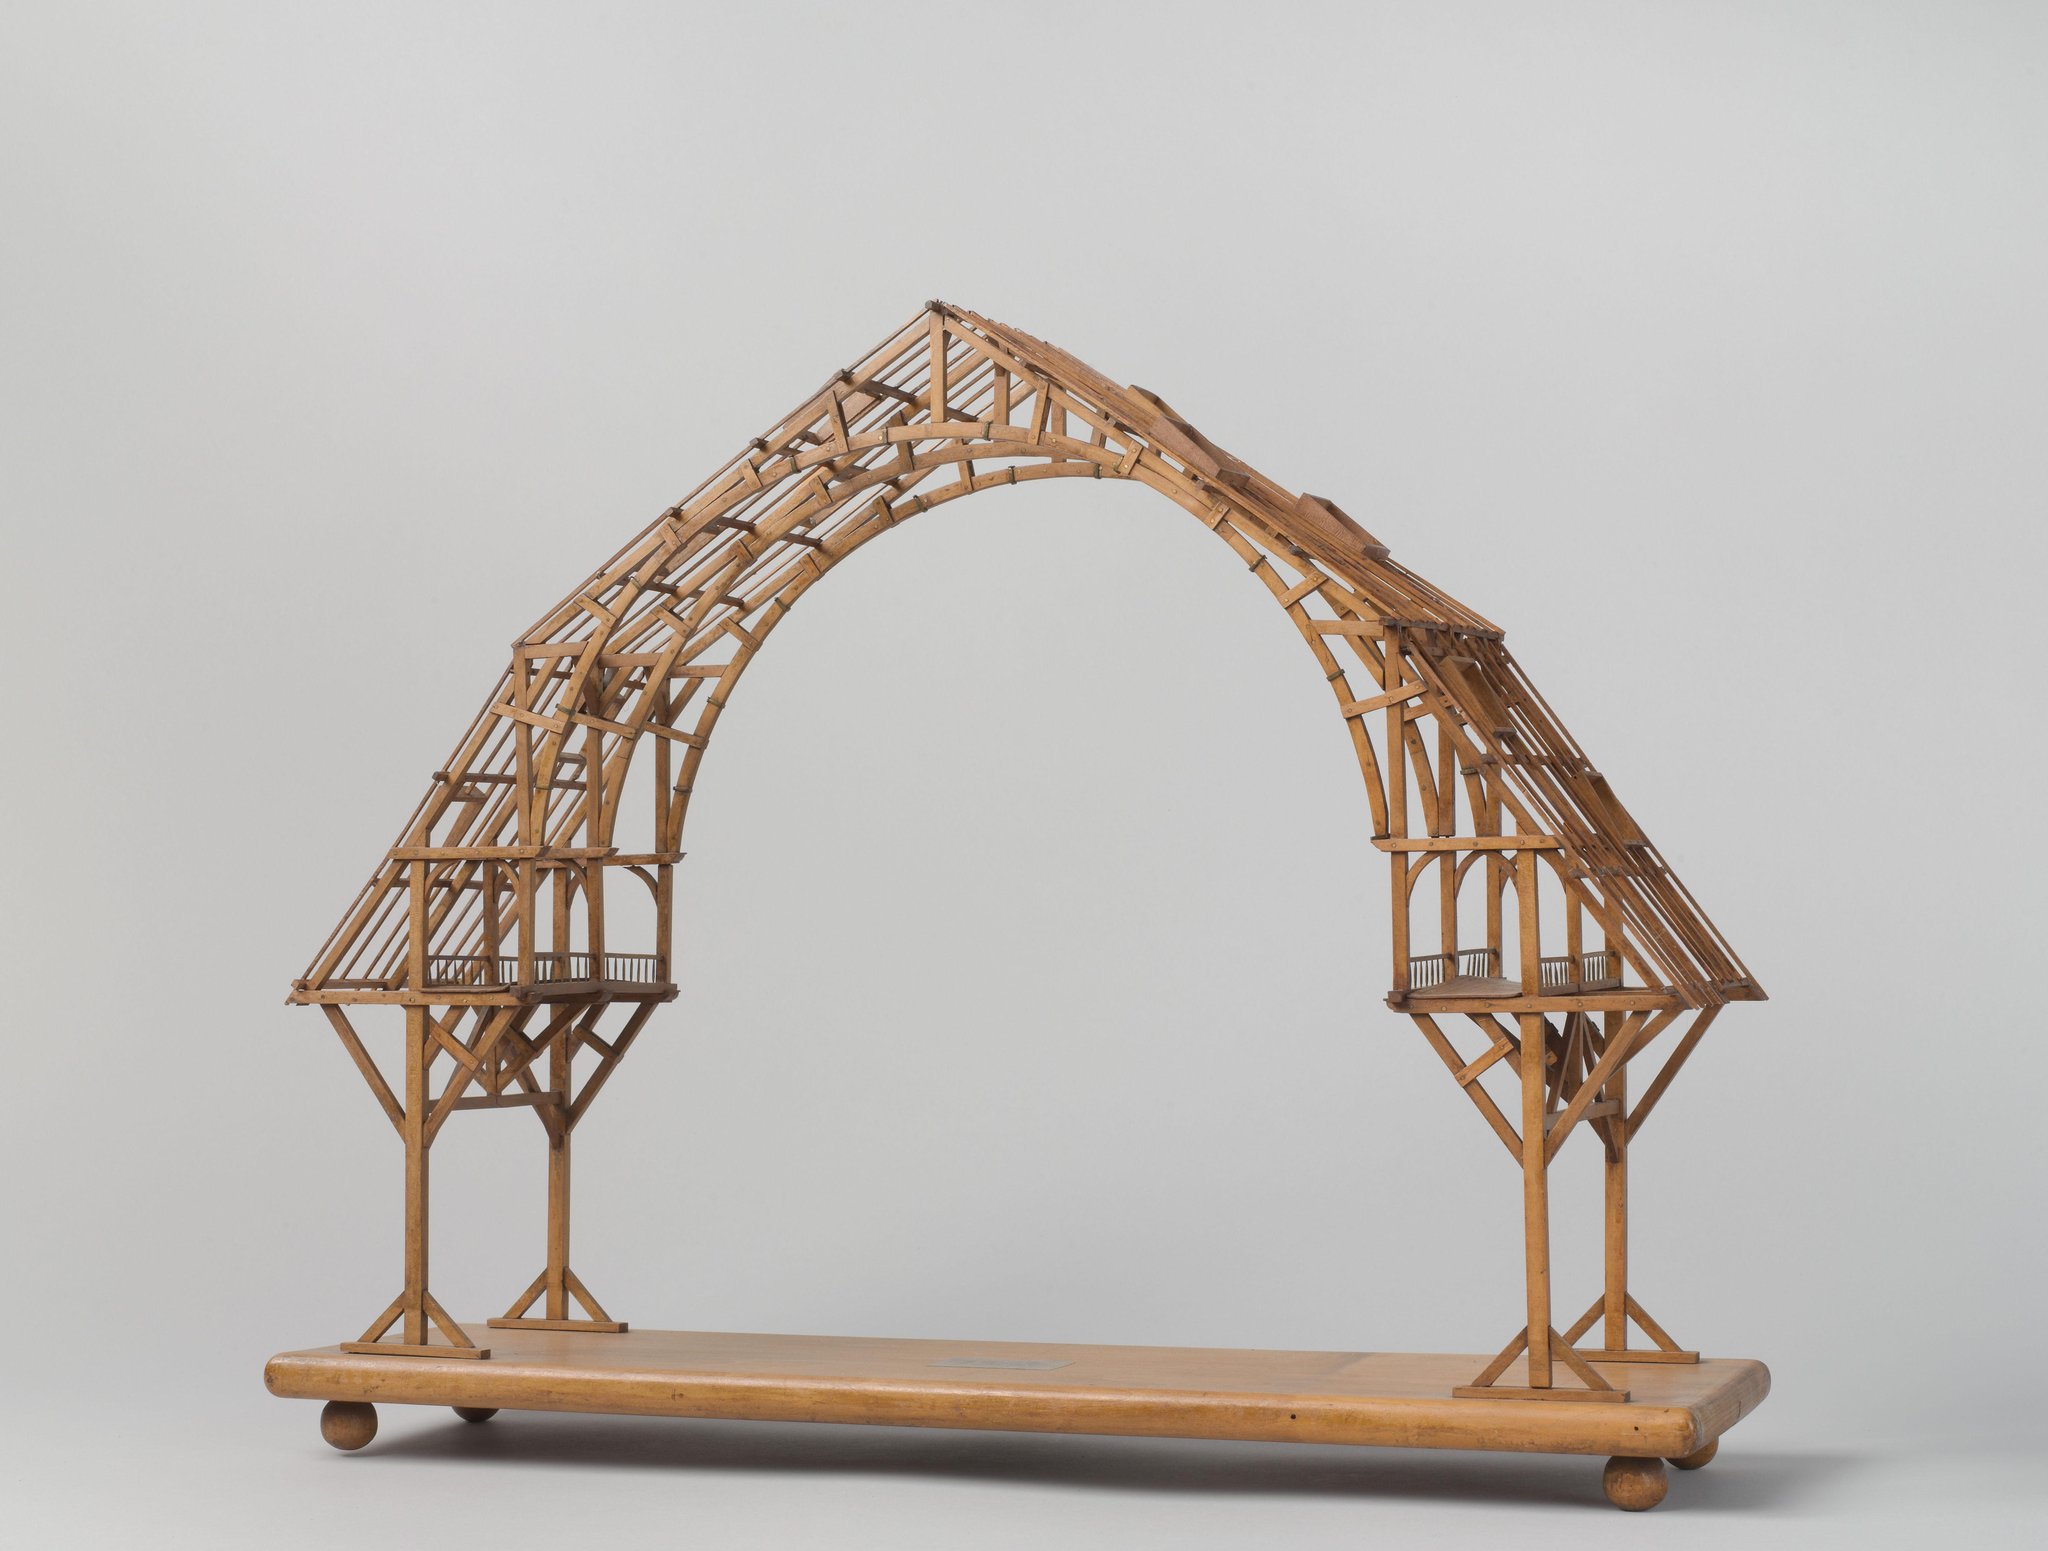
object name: demonstration model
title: Model of Part of the Roof of a Covered Slipway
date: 1850-1860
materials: brass, wood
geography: vlissingen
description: Een model van een scheepskap over de lengte van drie spanten werd in 1857 door de Rijkswerf te Vlissingen aan de de Oostenrijkse gezant gezonden: het zou zeer goed dit model of een copie ervan kunnen zijn geweest. De modelmakers van dat model, P. Dockheer (?) en J. de Haan (?), werden door de gezant met een Napoleon d'Or beloond.